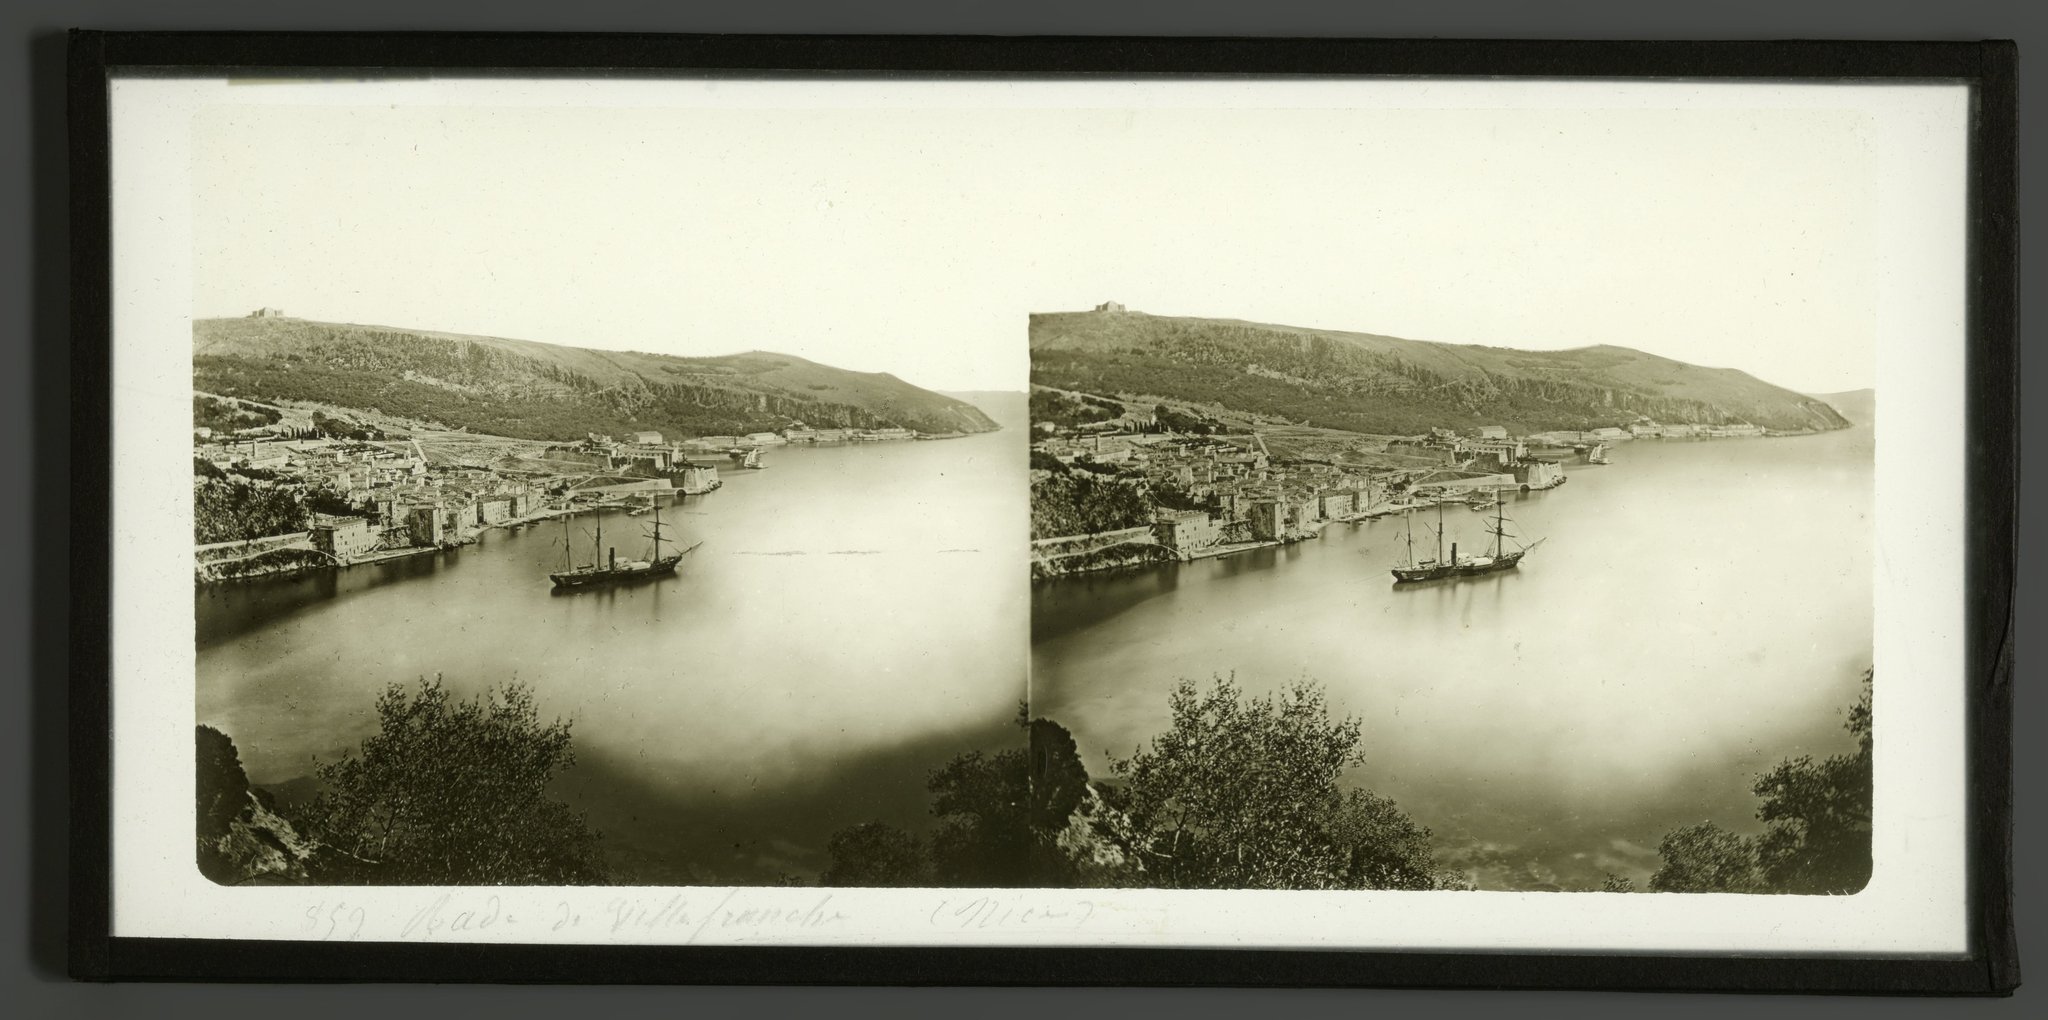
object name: stereoscopic photograph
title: Gezicht op Villefranche-sur-Mer, Frankrijk, met op de voorgrond een zeilschip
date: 1860-1870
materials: glass, paper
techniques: slide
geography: villefranche-sur-mer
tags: sailing-ship, sailing-boat, prospect of city, town panorama, silhouette of city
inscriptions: annotation: ‘859 Rade de Villefranche (Nice)’